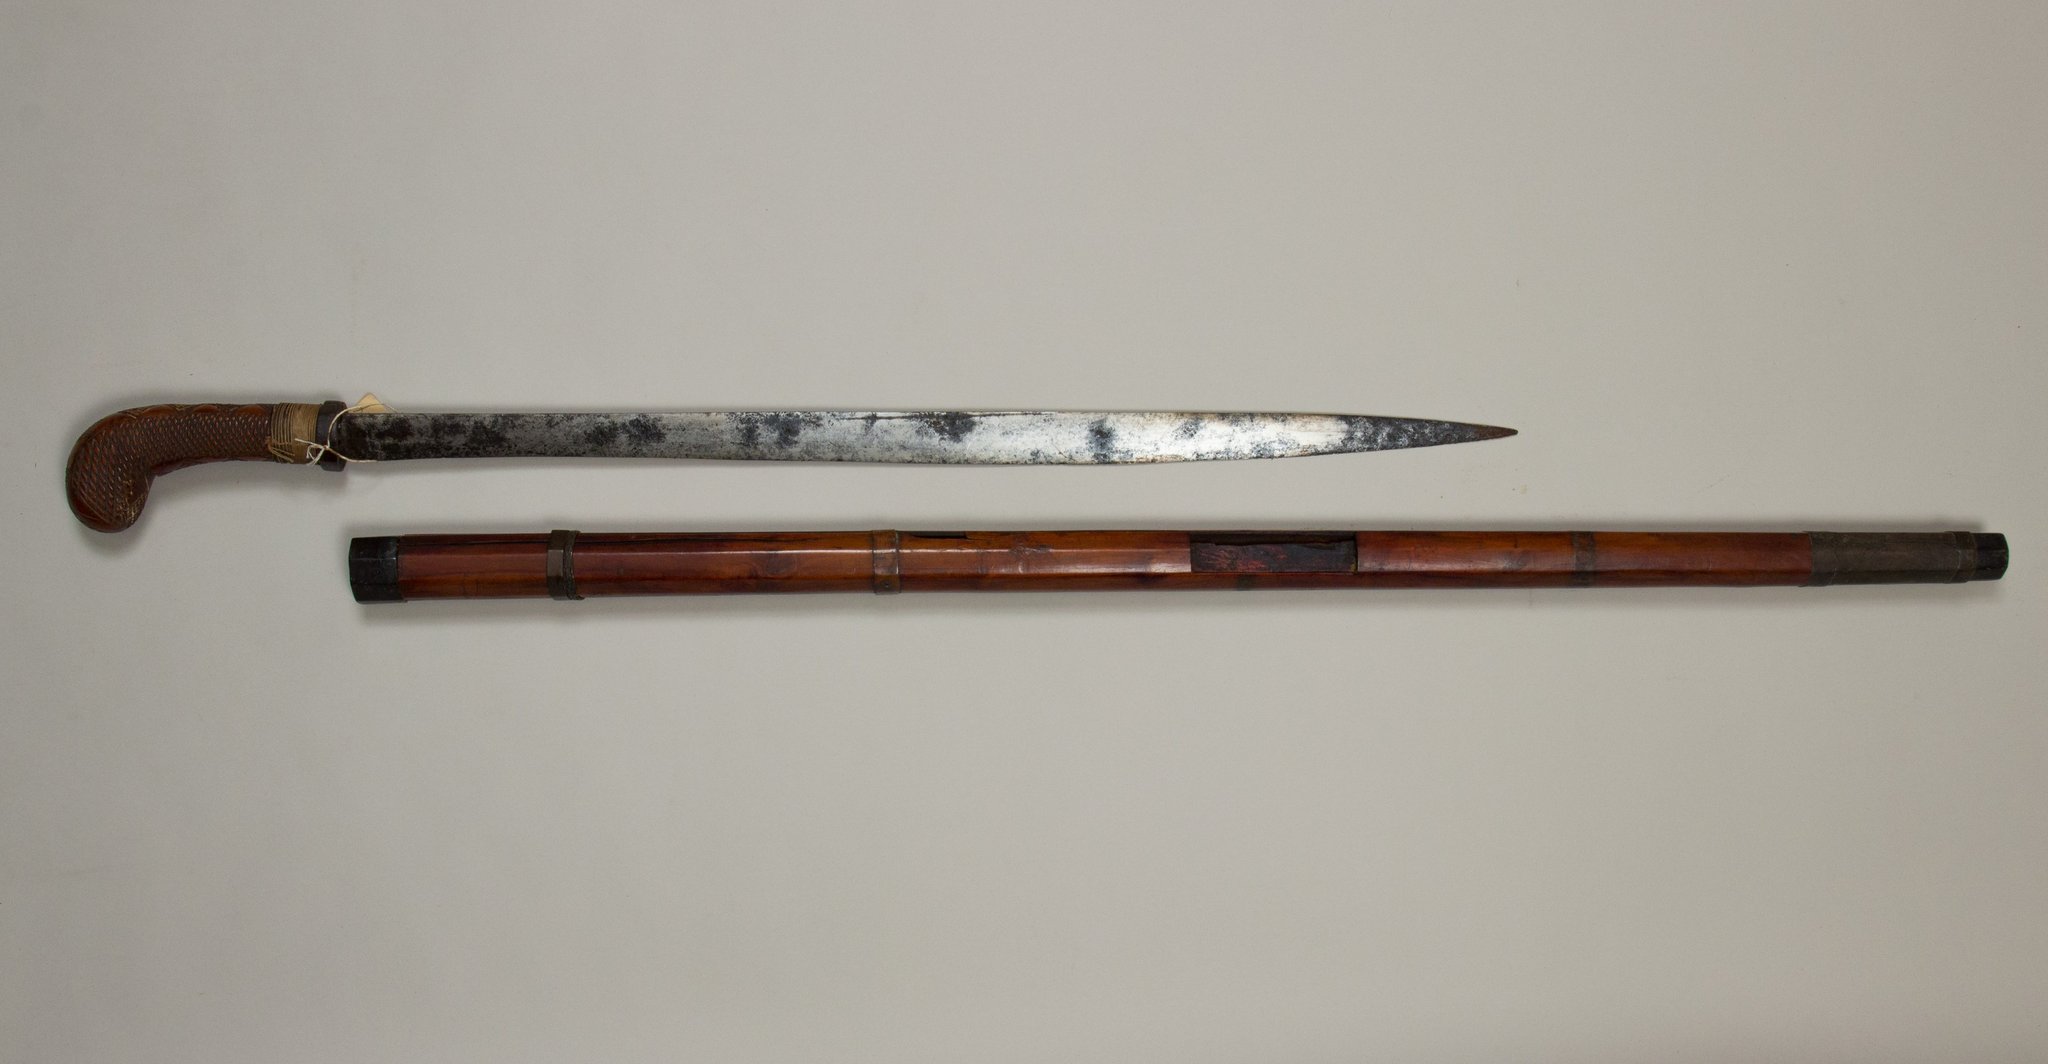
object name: sword cane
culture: philippine, moro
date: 1701-1900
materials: brass, horn, steel, wood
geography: philippines